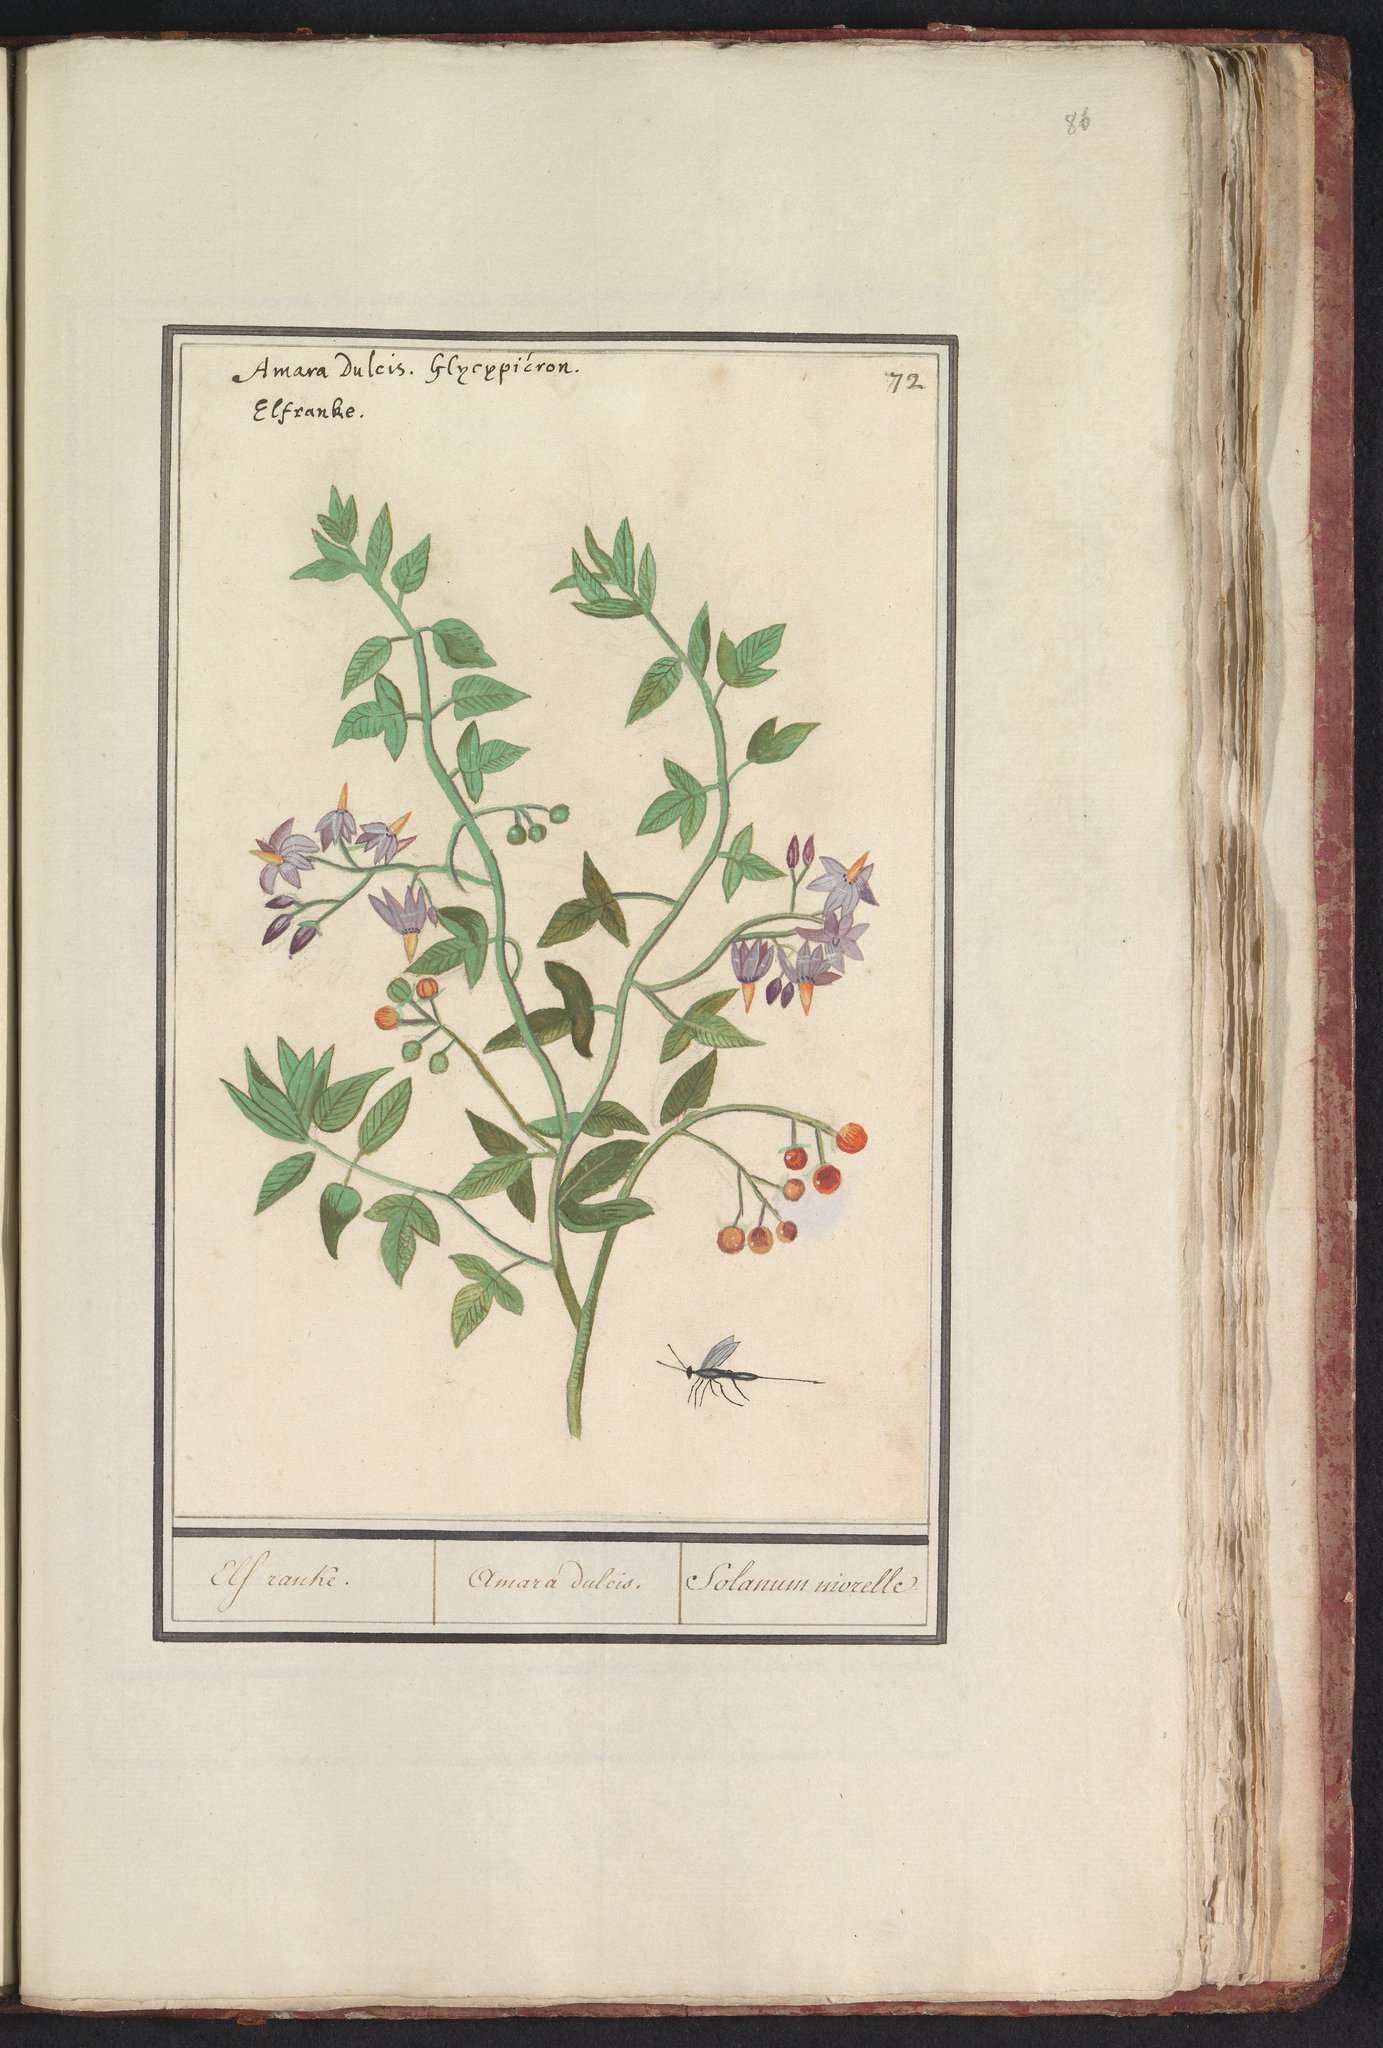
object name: drawing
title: Bitterzoet (Solanum dulcamara)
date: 1596-1610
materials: chalk, paint, ink, paper, watercolor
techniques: brush, pen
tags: plants and herbs: bittersweet, insects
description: Bitterzoet, elf-rank of klimmende nachtschade. Met een mug of vlieg. Genummerd rechtsboven: 72. Linksboven de Latijnse en Nederlandse naam. Onderdeel van het eerste album met tekeningen van bloemen en planten. Achtste van twaalf albums met tekeningen van dieren, vogels en planten bekend rond 1600, gemaakt in opdracht van keizer Rudolf II. Met toelichting in Nederlands, Latijn en Frans.